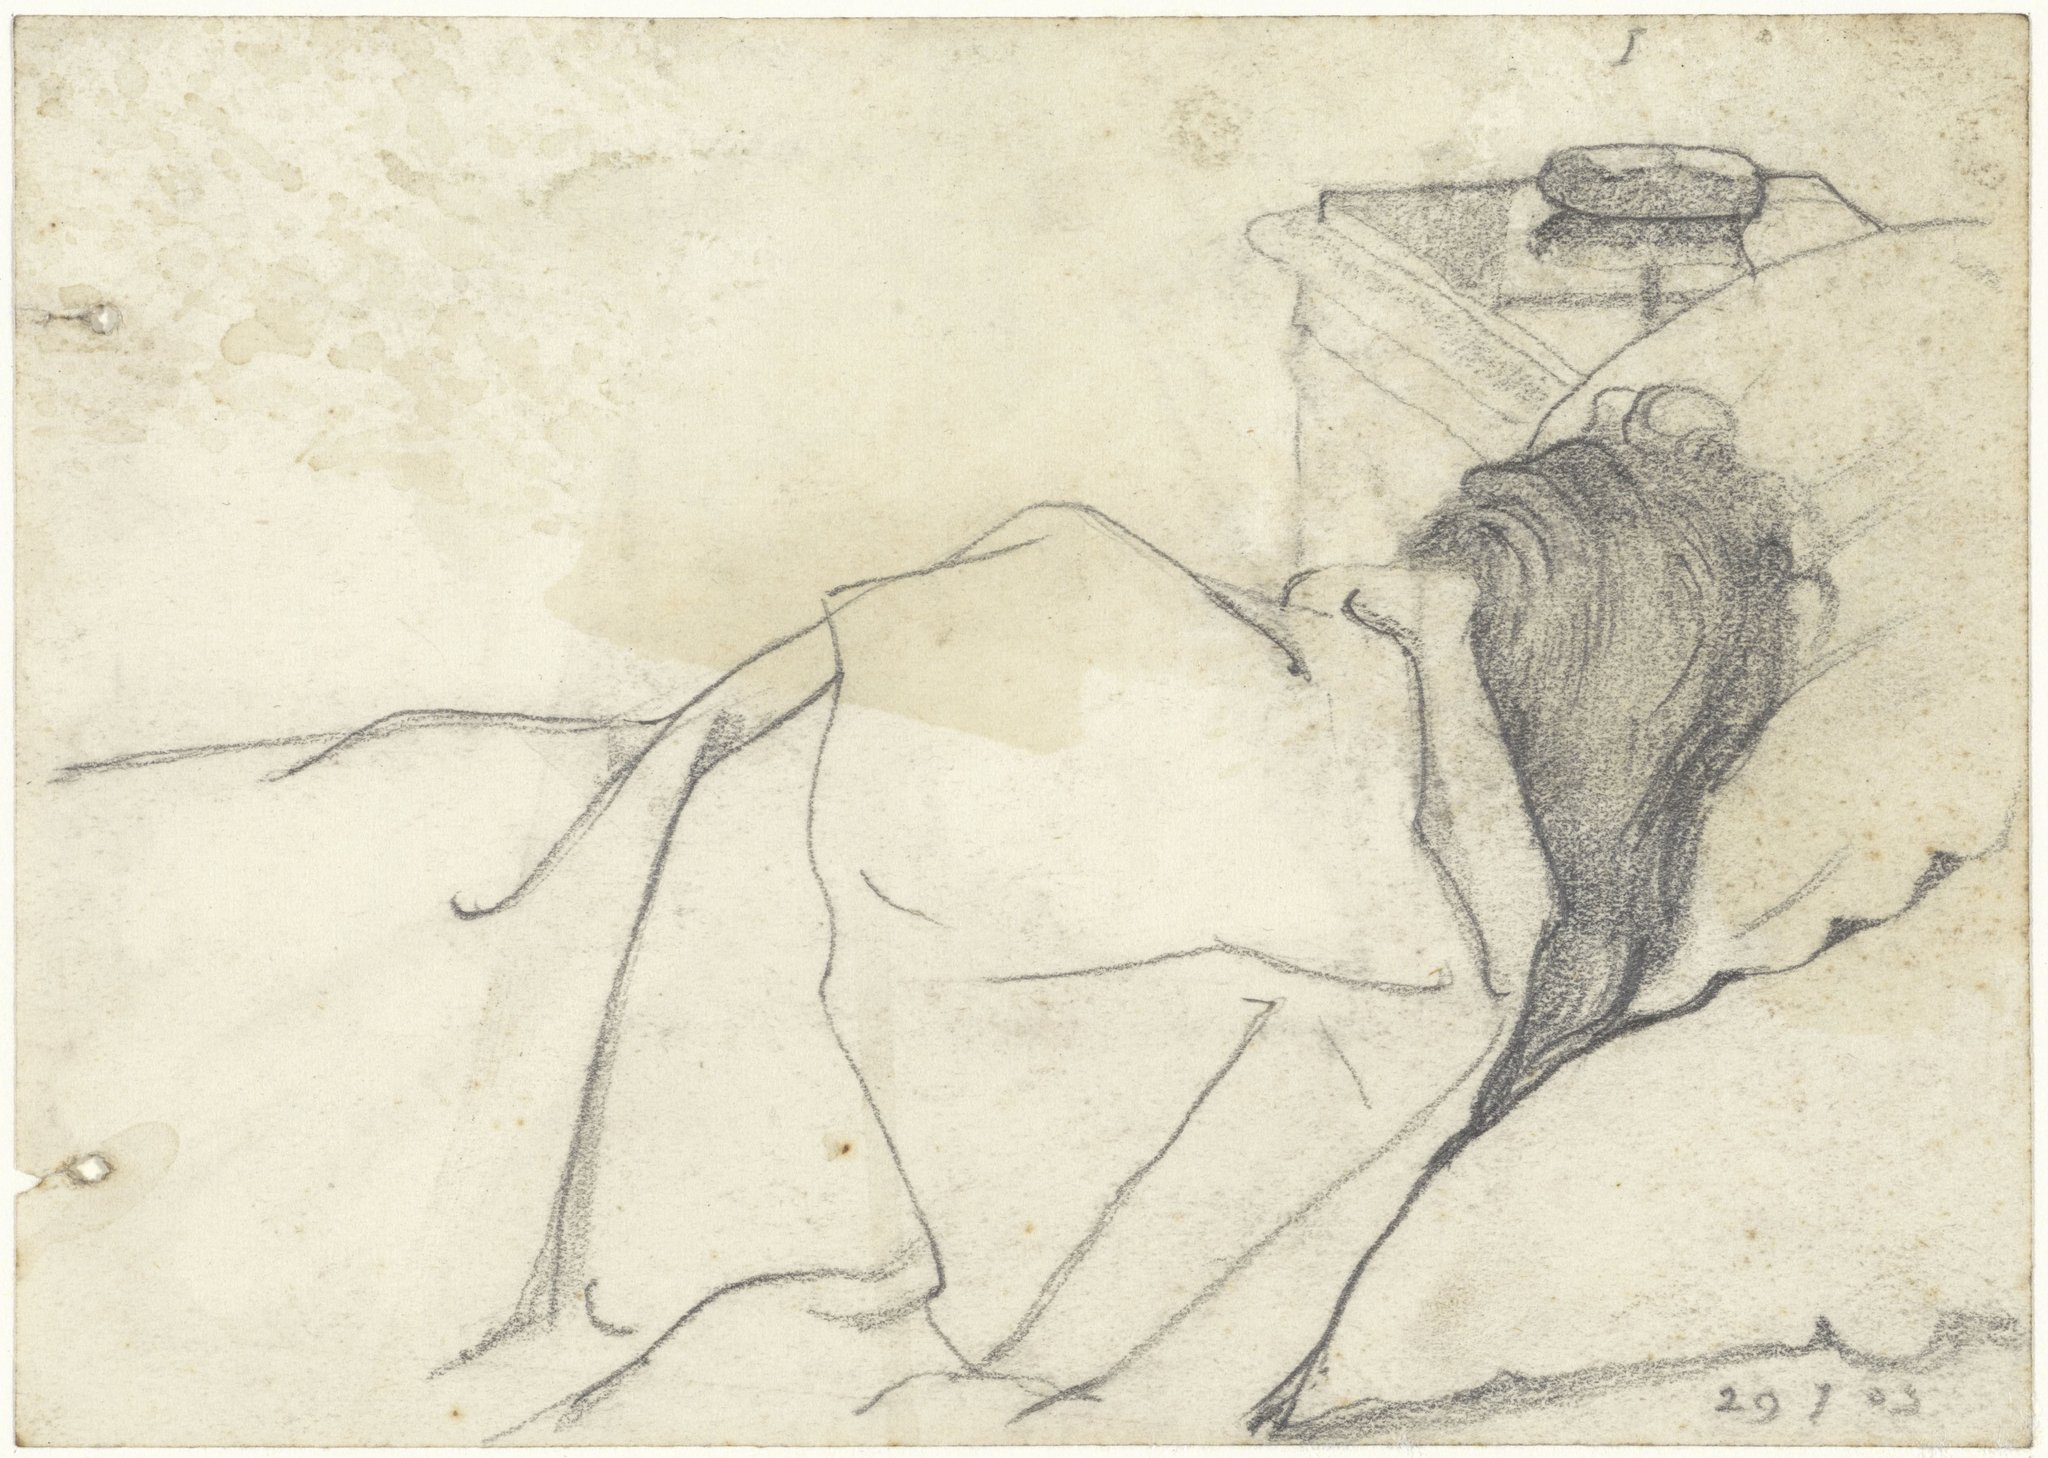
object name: drawing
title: Vrouw van Richard Roland Holst in bed met afgewend gezicht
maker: richard nicolaüs roland holst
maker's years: 1868-1938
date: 1903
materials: paper, pencil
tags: amsterdam, henriëtte roland holst-van der schalk, historical persons - bb - woman, sleeping; unconsciousness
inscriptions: date: ‘29 7 03’